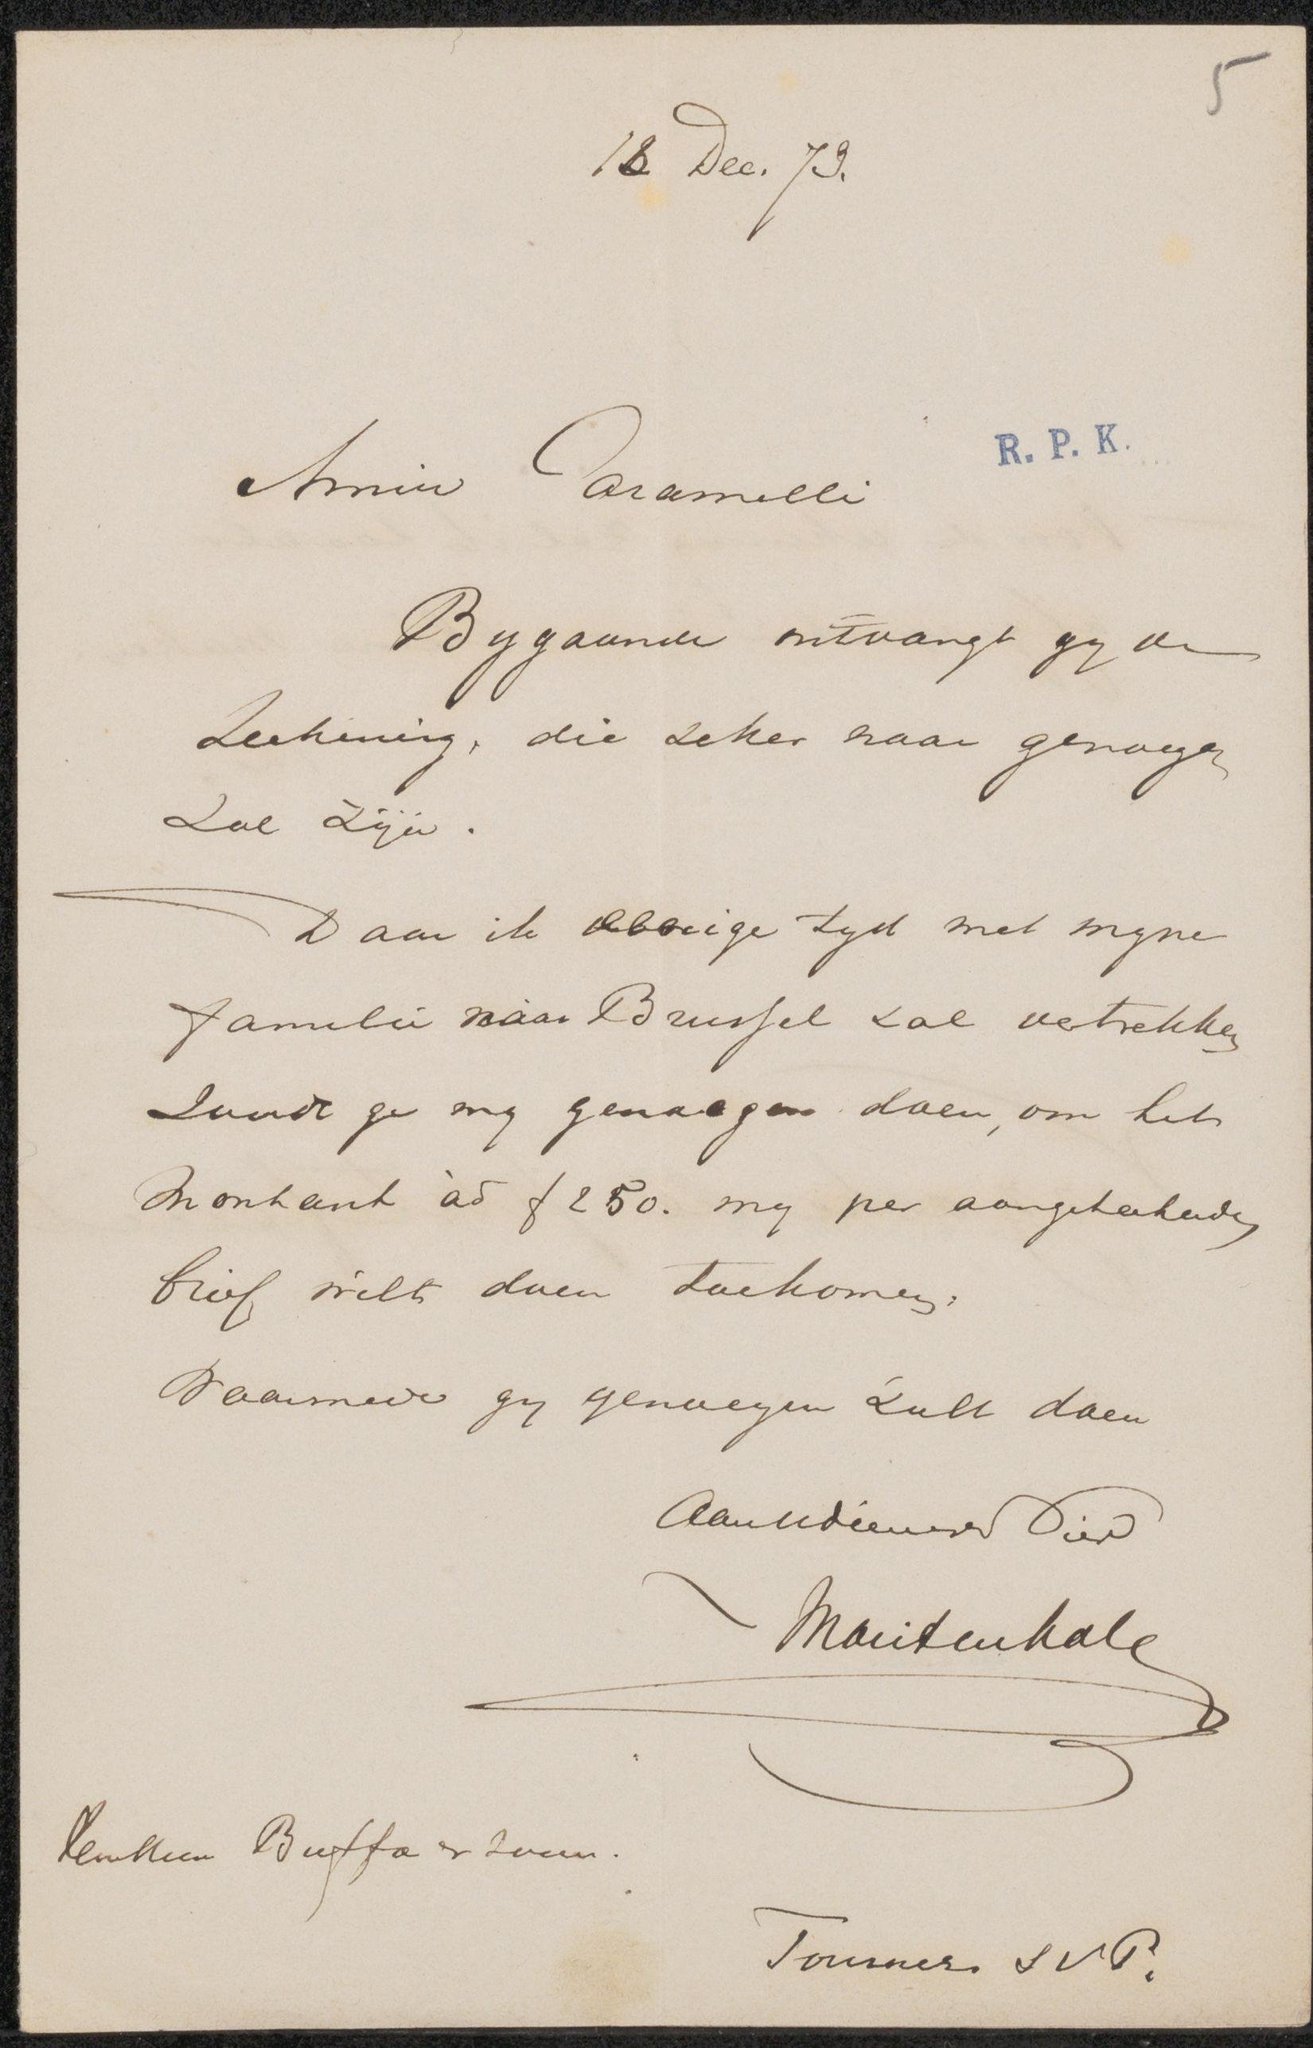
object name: letter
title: Brief aan de heer Caramelli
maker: mari ten kate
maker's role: draughtsman, painter, print maker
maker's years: 1831-1910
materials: ink, paper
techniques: pen, writing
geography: the hague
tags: publisher, art trade, art shop, drawing, family life, money, brussels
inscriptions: collector's mark: Lugt 2233